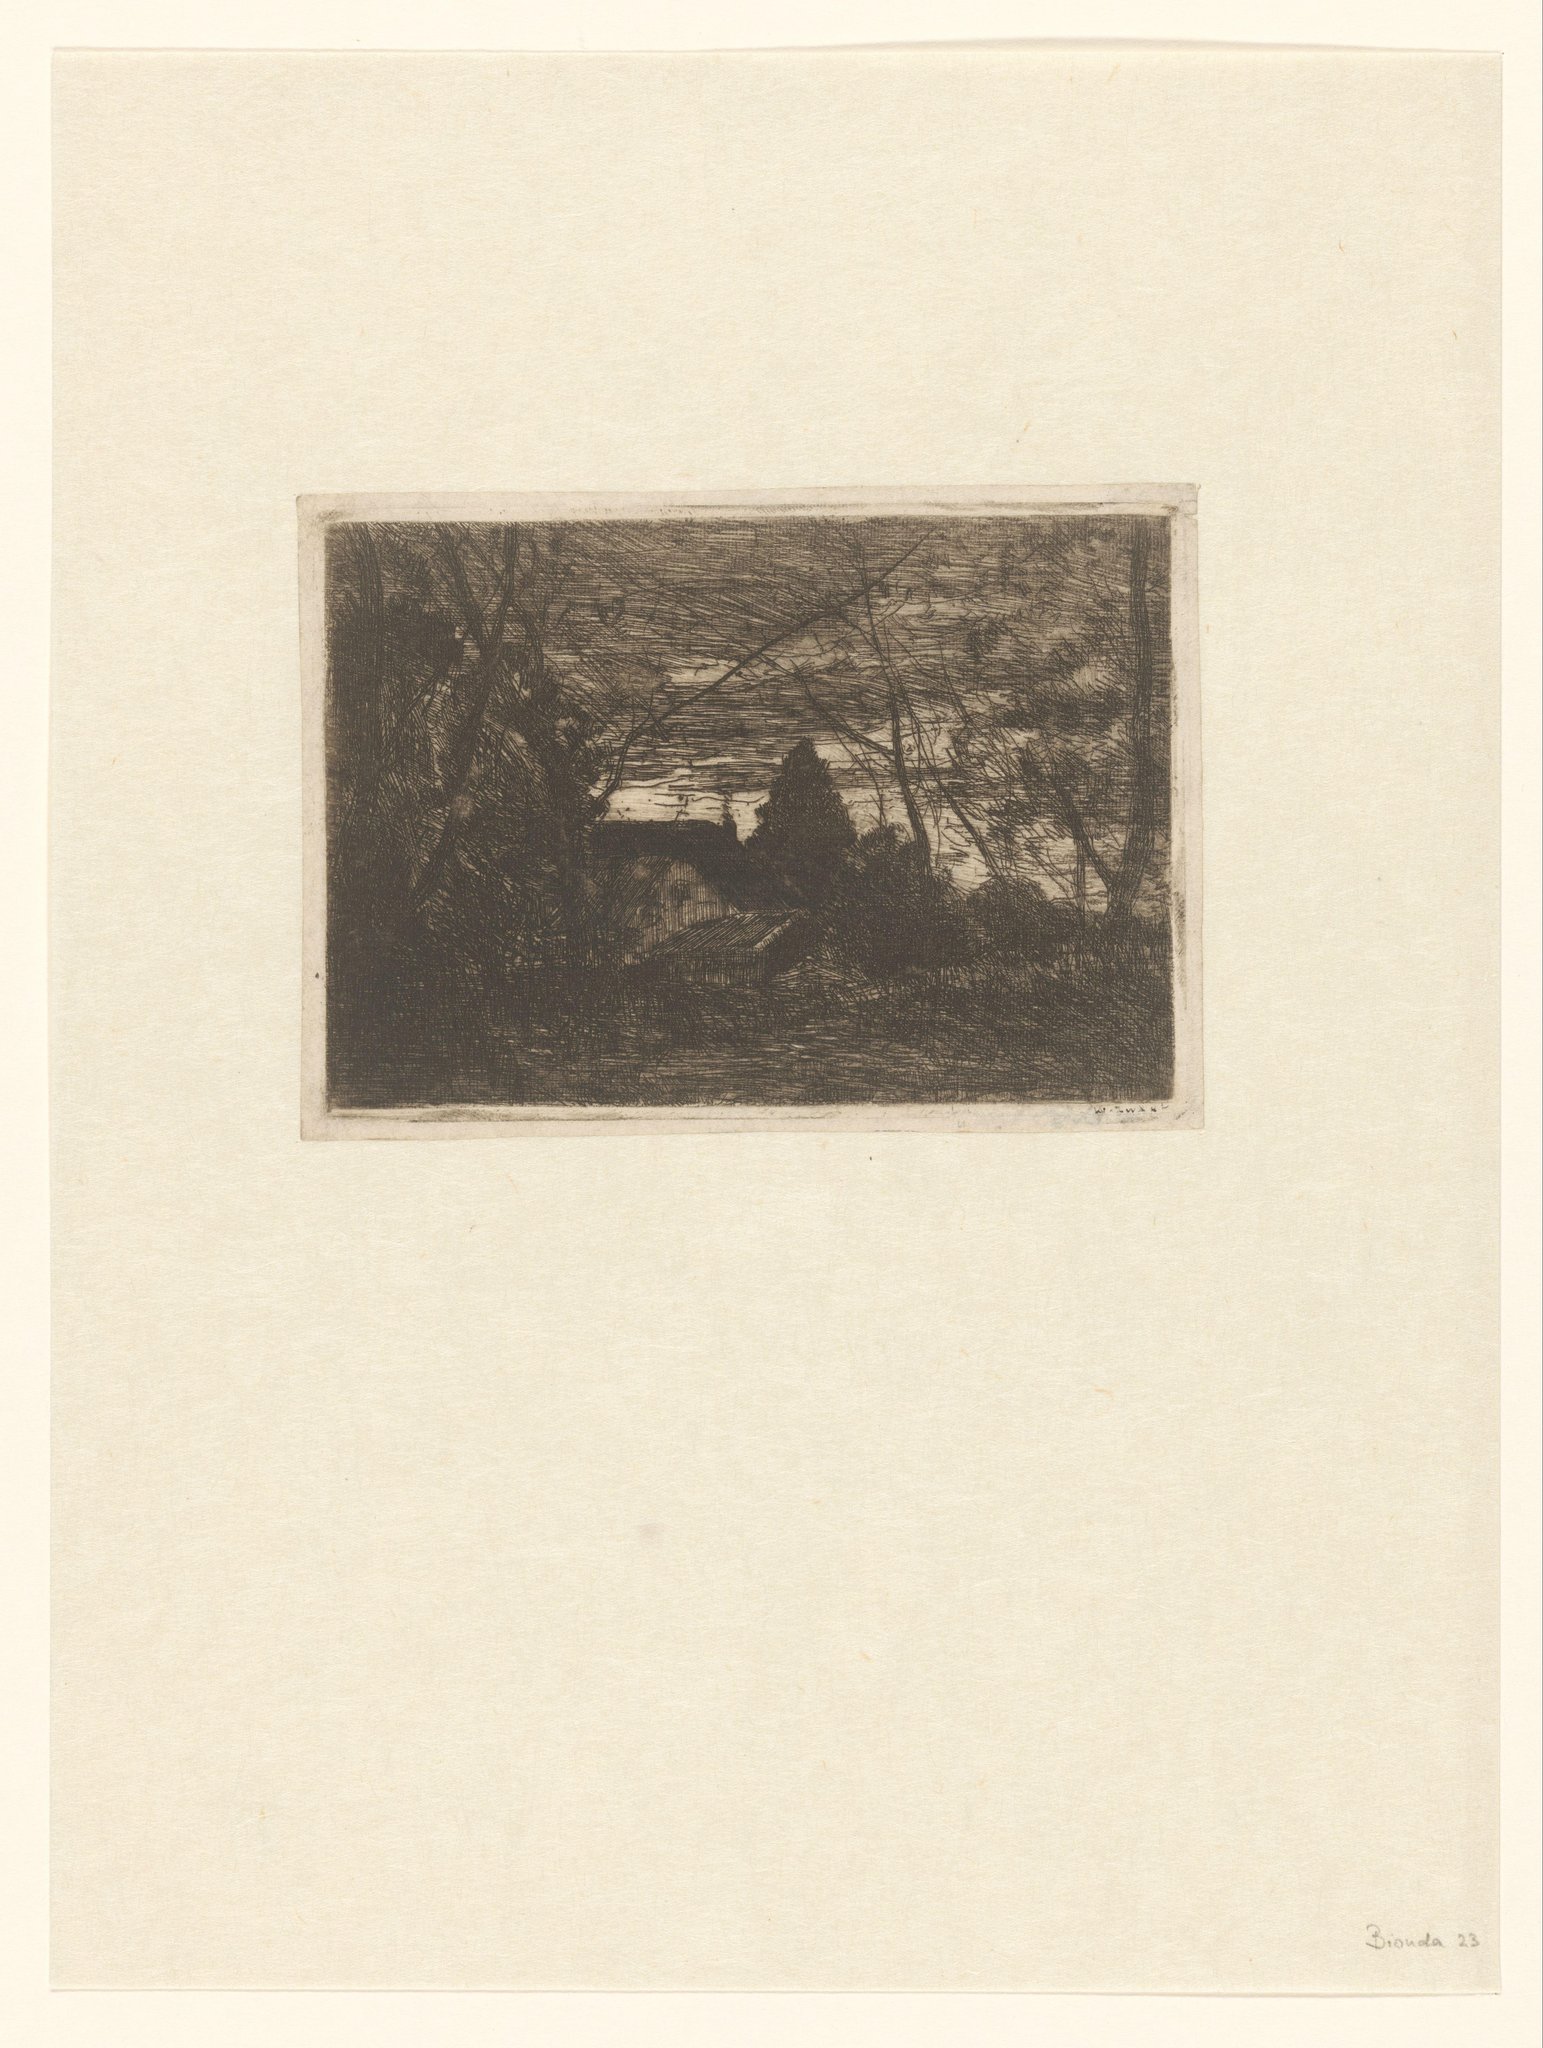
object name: print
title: Landschap met boerderij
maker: willem de zwart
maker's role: draughtsman, painter, print maker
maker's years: 1862-1931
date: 1885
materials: paper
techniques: drypoint, etching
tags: evening, farm or solitary house in landscape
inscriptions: collector's mark: Lugt 2228, annotation: ‘de kleur van de inkt/ als de andere, dus niet zoo bruin/ deze afdruk is [...]. svp de lichte/ [...]’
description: Prent verscheen in 1886 als onderdeel van de jaarlijkse uitgave van de 'Portefeuille der Nederlandsche Etsclub'.